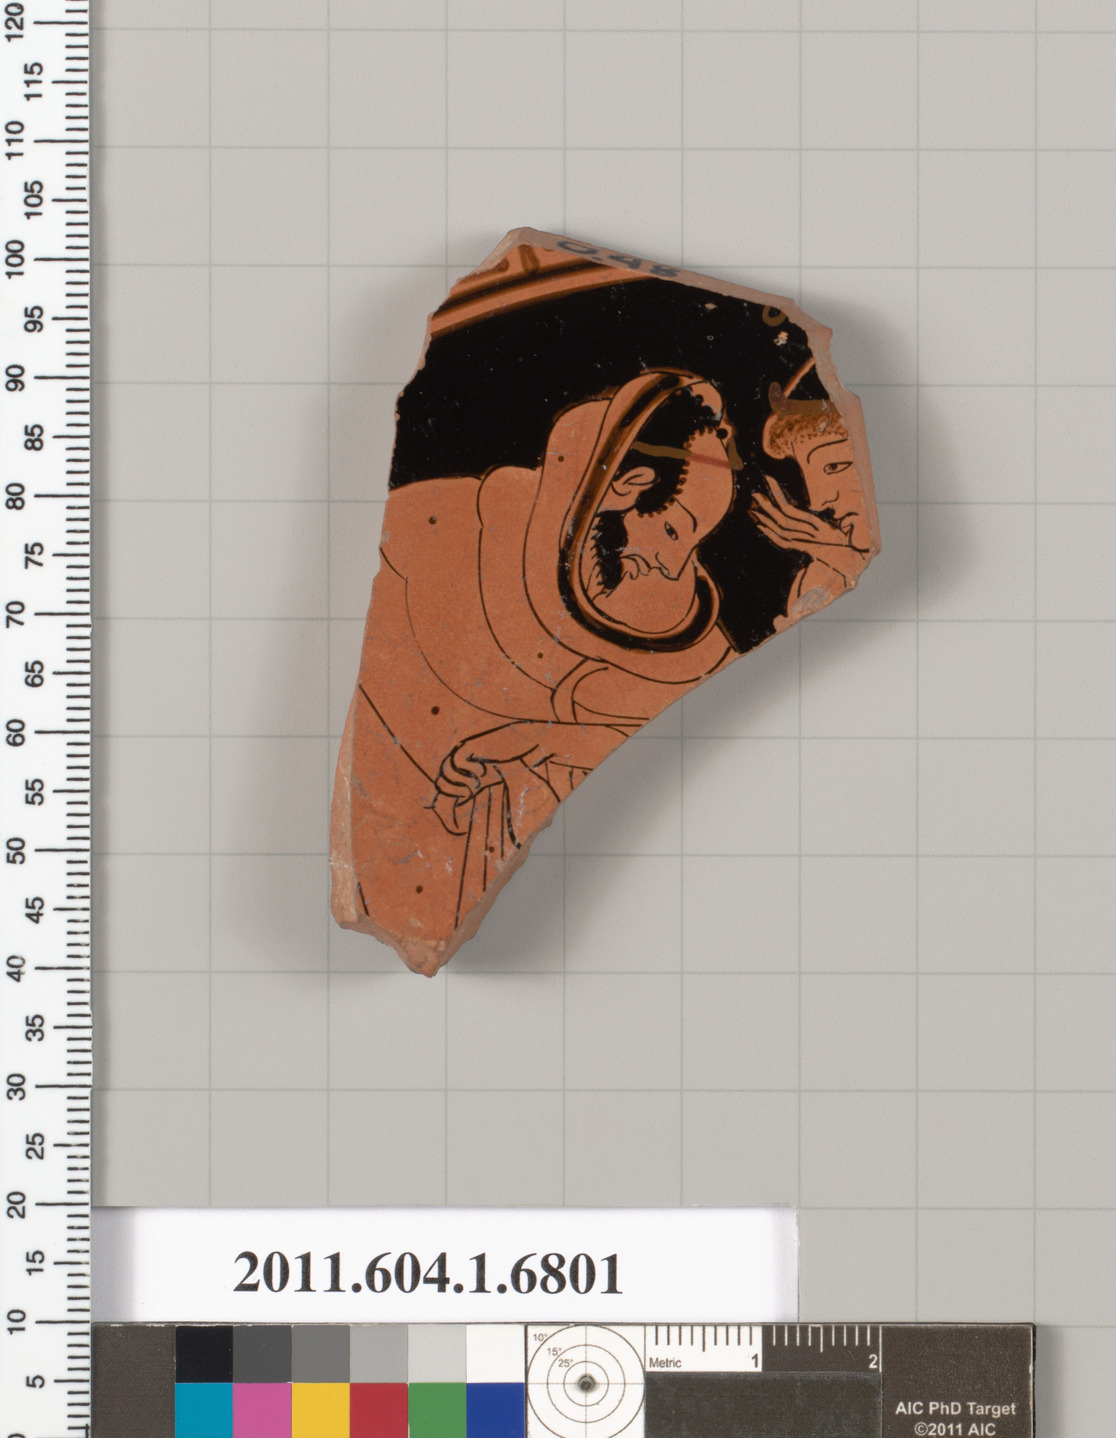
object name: kylix fragment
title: Terracotta fragment of a kylix (drinking cup)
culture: greek, attic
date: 490-480 BCE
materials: terracotta